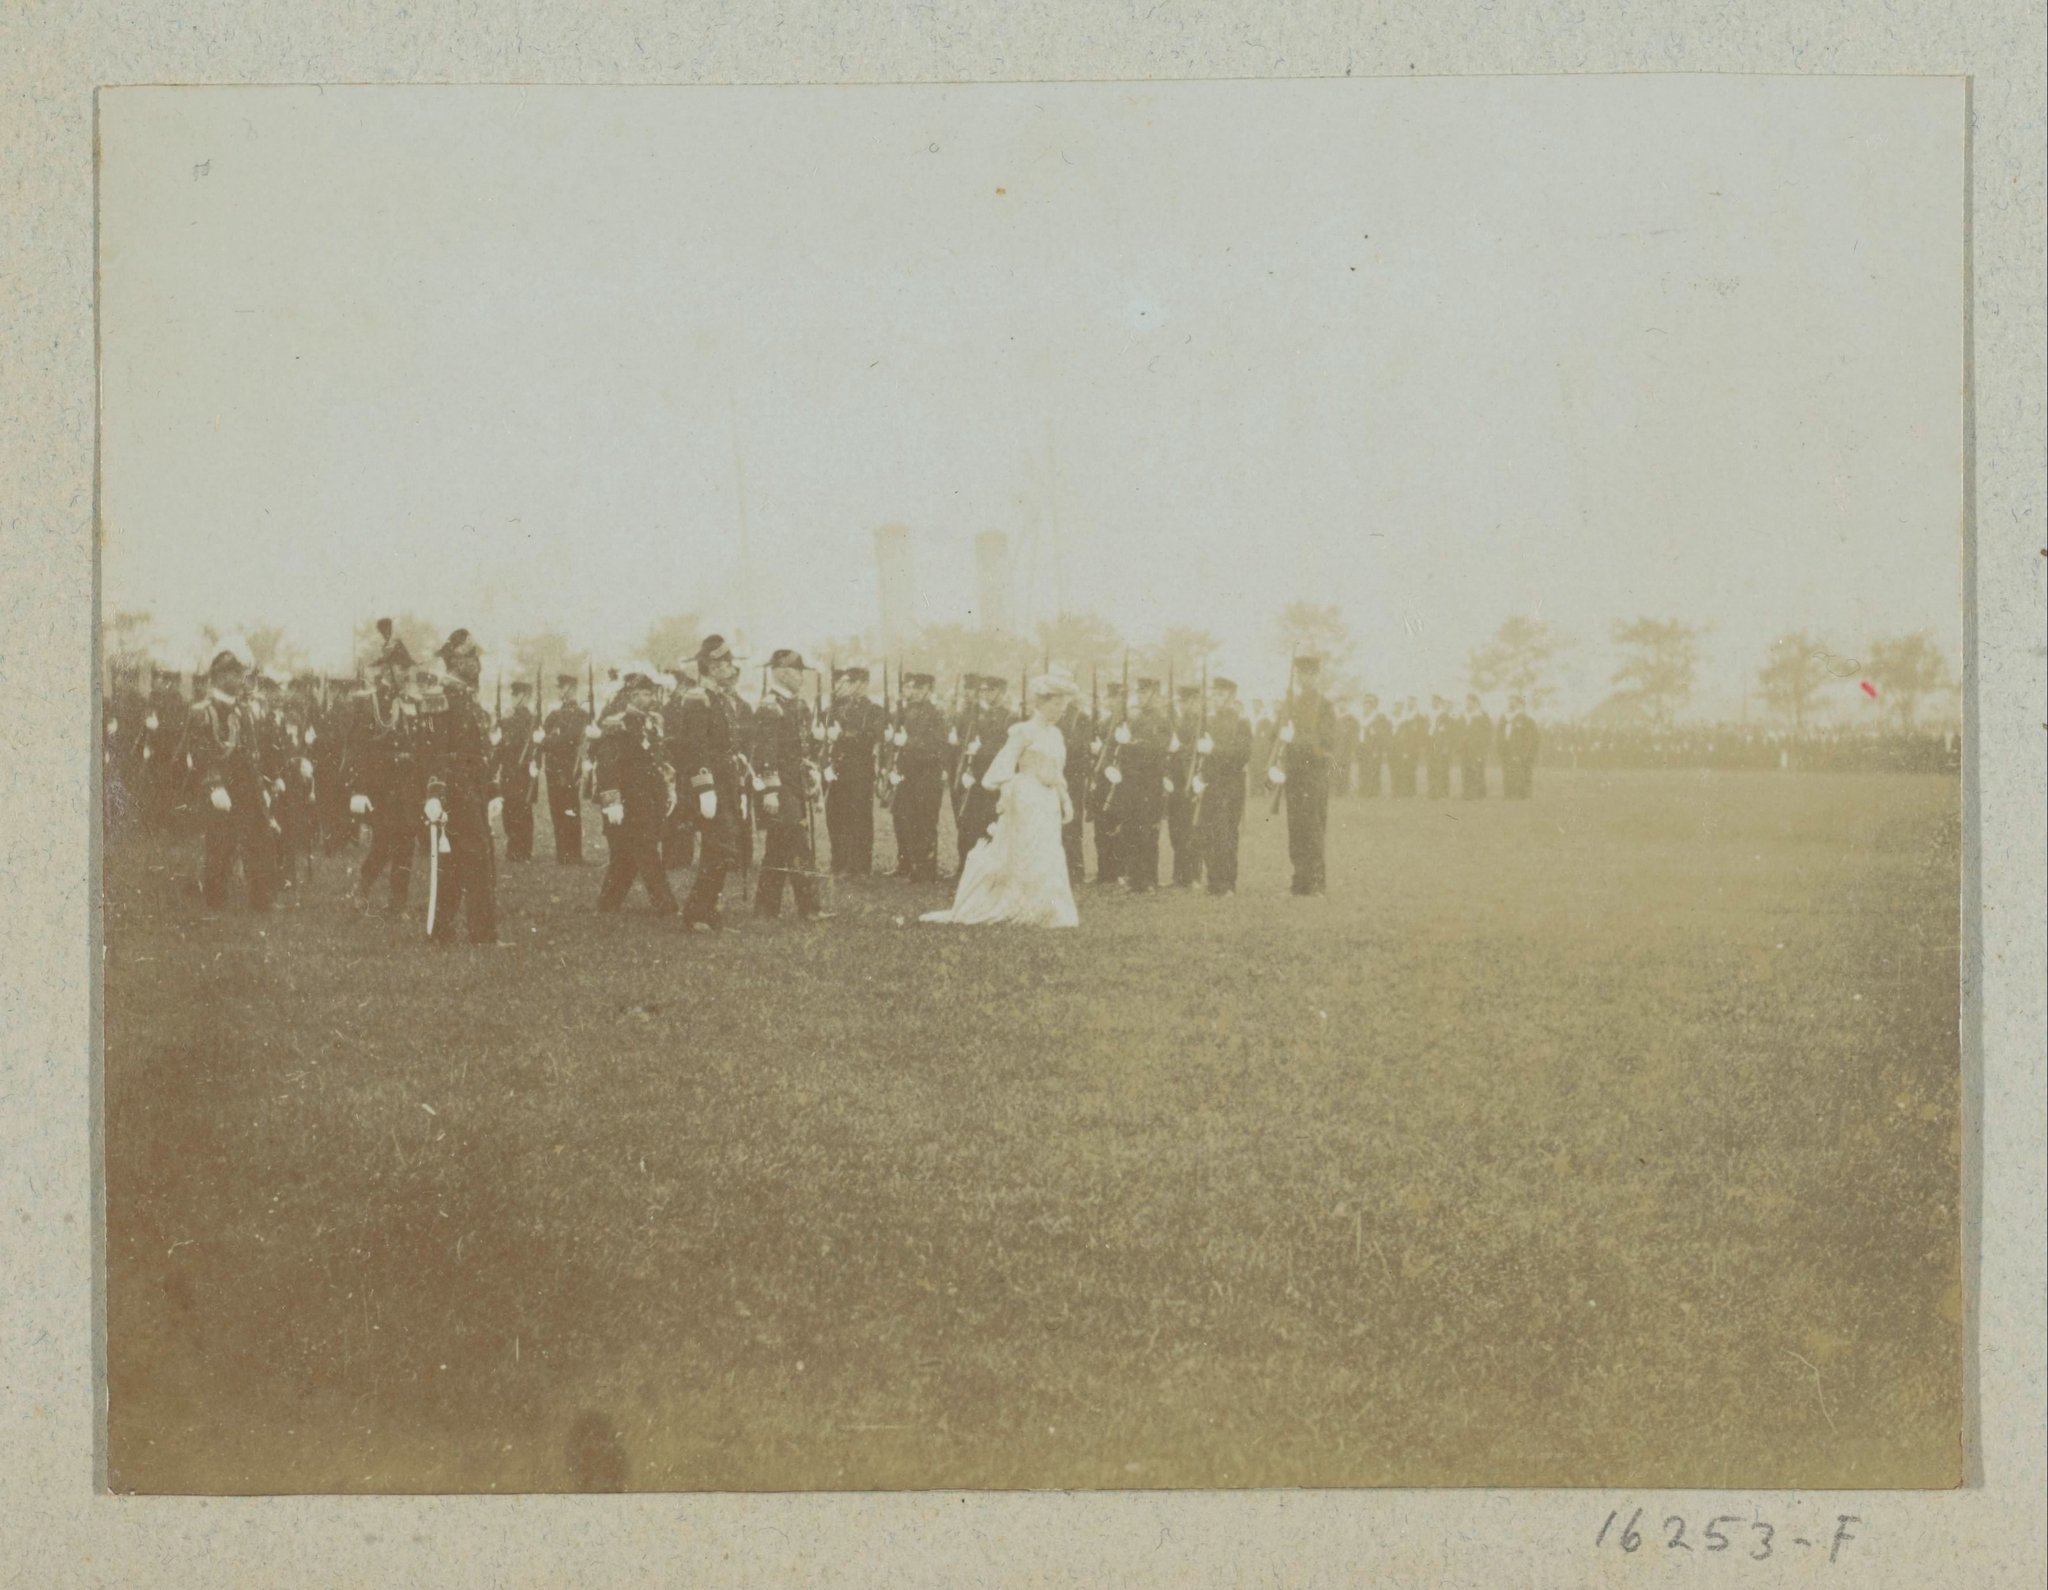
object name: photograph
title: H.M. de Koningin bij de vaandeluitreiking op 's Rijkswerf te Willemsoord 14 September 1904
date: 1904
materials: paper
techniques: collodion silver print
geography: willemsoord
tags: the hague, print maker, wilhelmina of the netherlands, queen, military parade, pageant